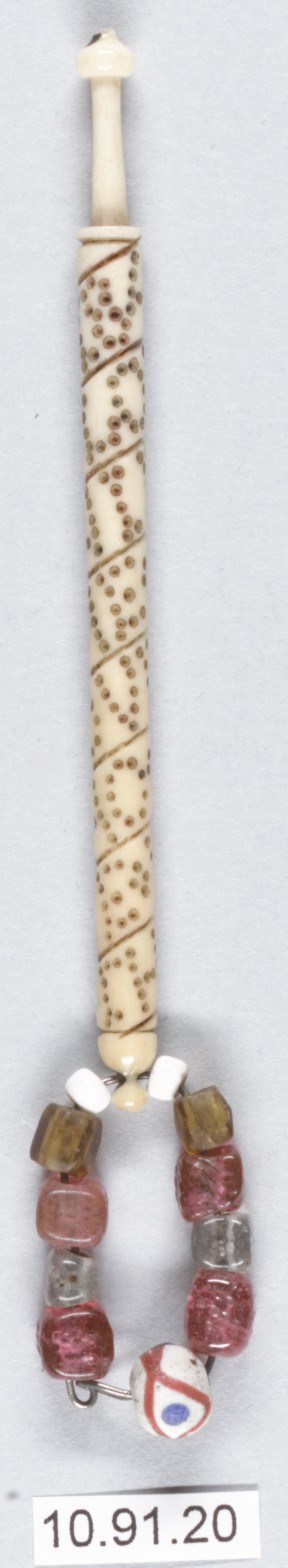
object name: bobbin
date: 1842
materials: bone